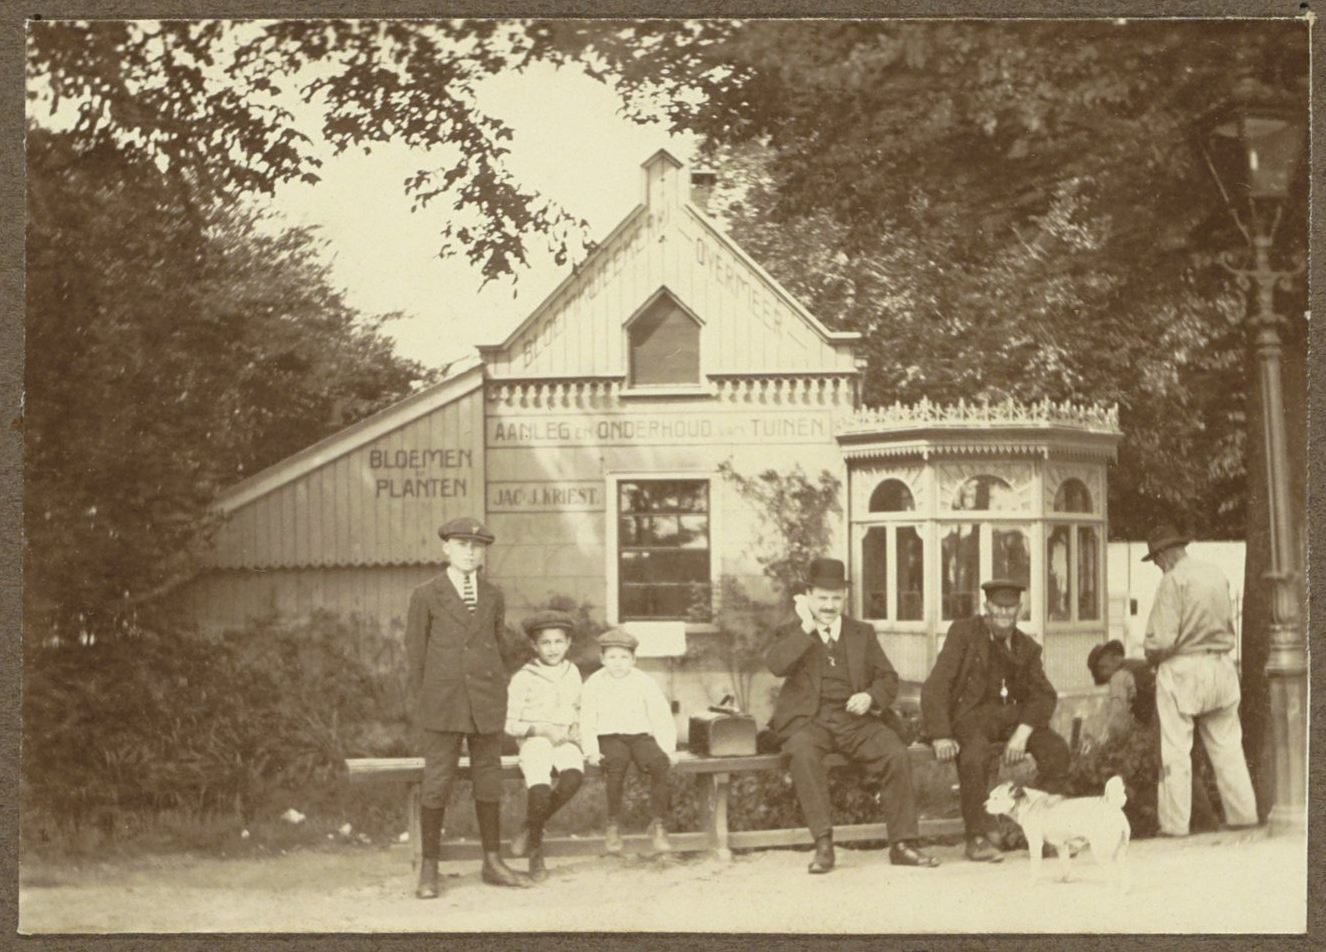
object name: photograph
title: Mannen en kinderen voor bloemen- en plantenkwekerij Overmeer (eigenaar Jac. J. Kriest) aan de Amsteldijk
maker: Anonymous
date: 1910-1930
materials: paper, photographic support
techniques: gelatin silver print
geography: amsterdam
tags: agriculture, cattle-breeding, horticulture, flowerculture, etc., amsterdam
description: Onderdeel van Album met foto's van Amsterdam en omgeving.